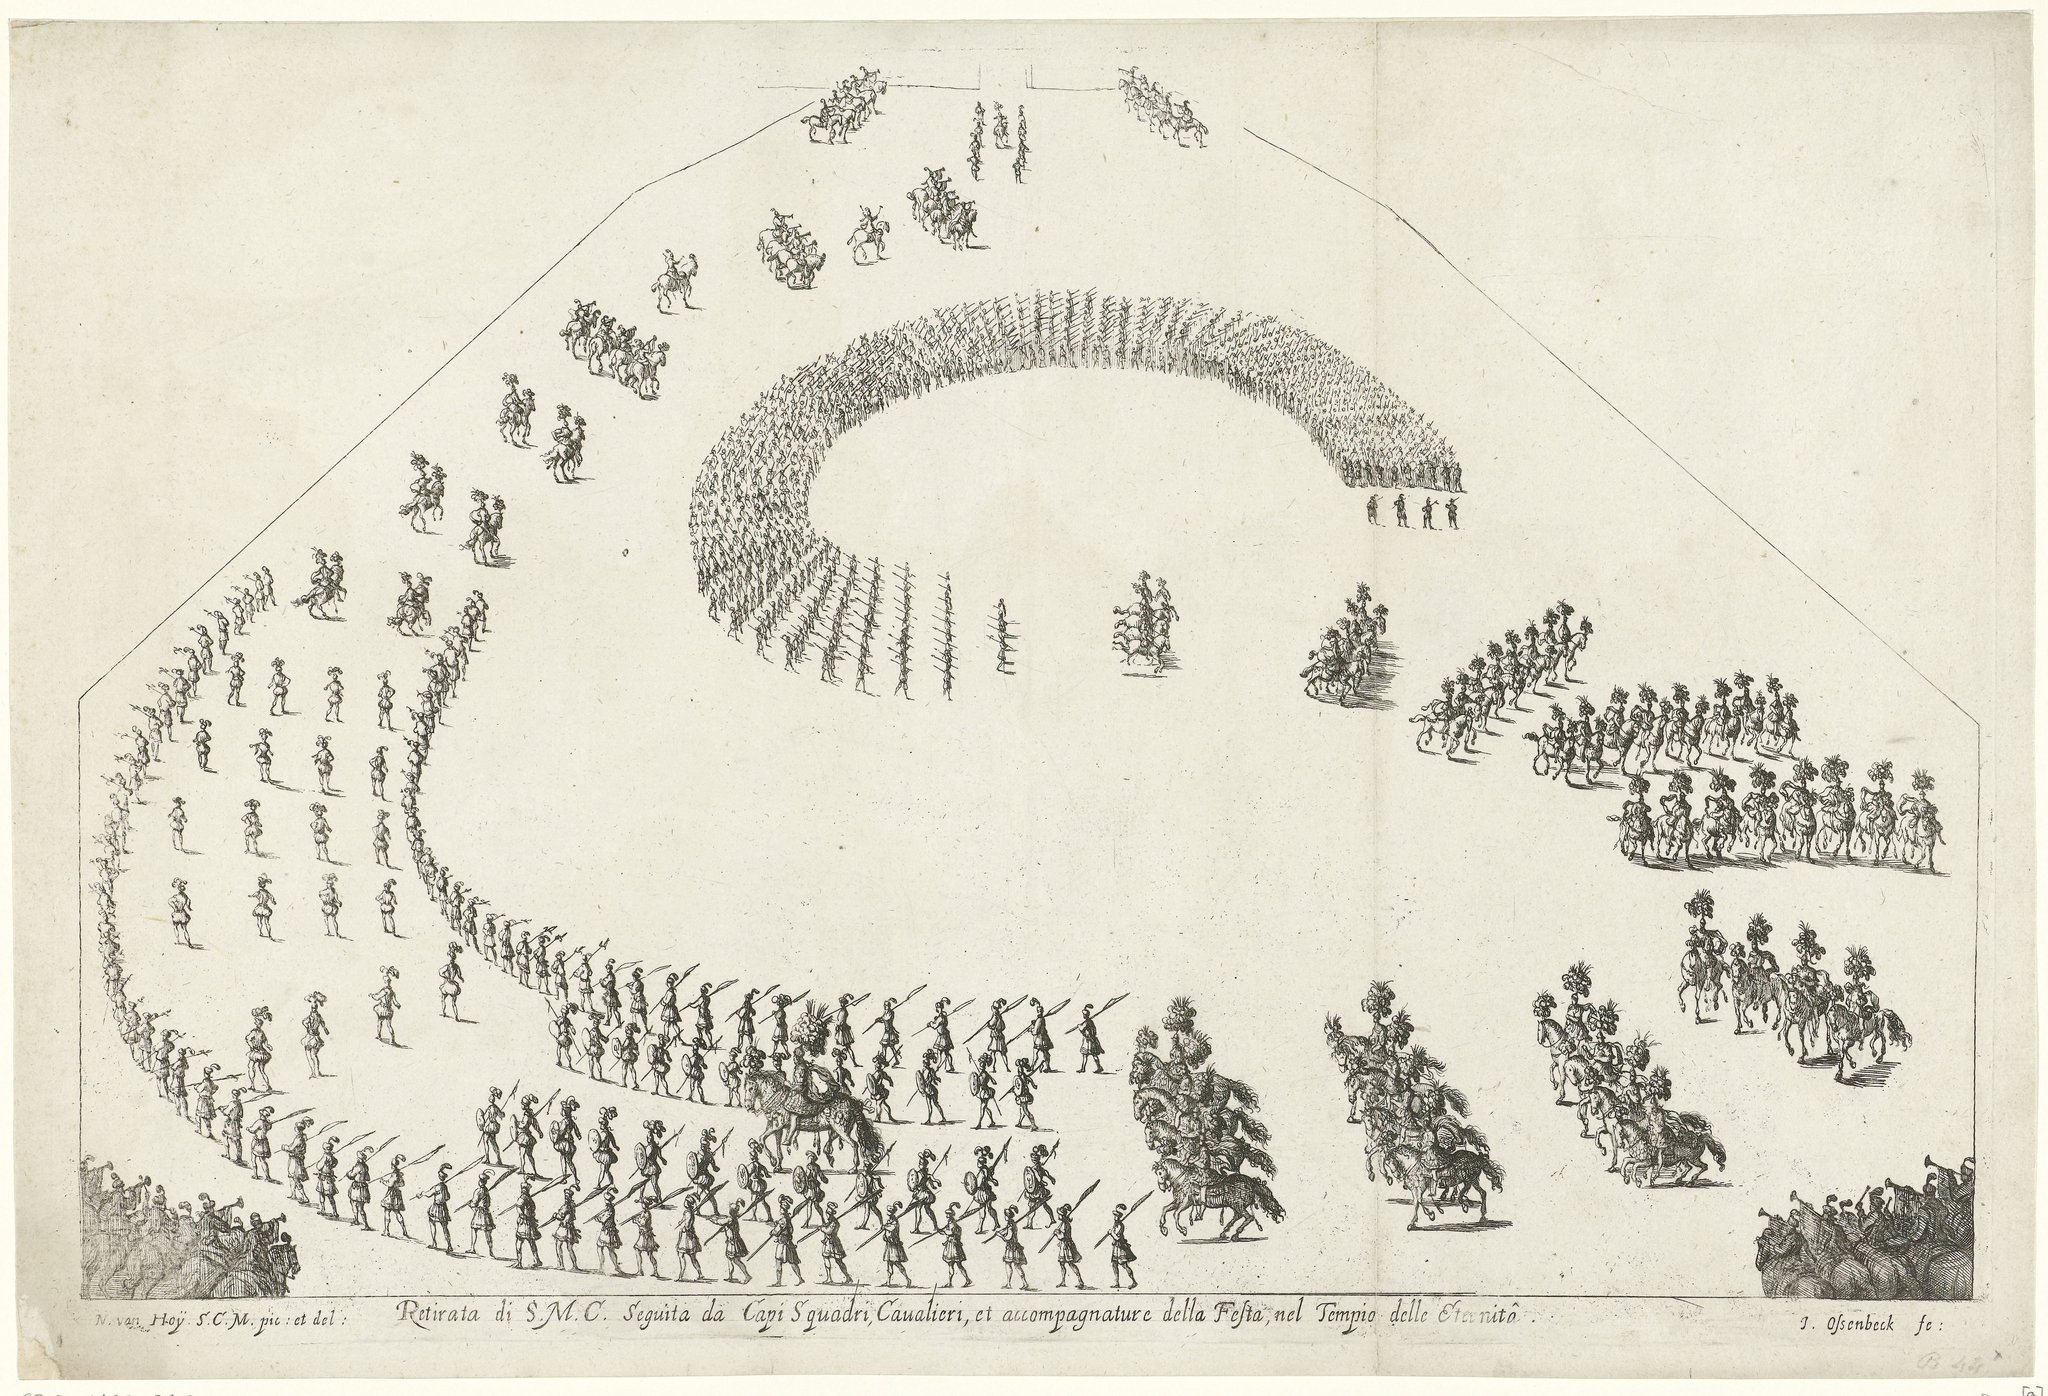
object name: print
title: Ballet te paard bij gelegenheid van het huwelijk van keizer Leopold I en Margaretha Theresia van Spanje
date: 1667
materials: paper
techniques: etching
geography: vienna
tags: military honours (+ infantry), high-school riding, military honours (+ cavalry, horsemen)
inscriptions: collector's mark: Lugt 2228